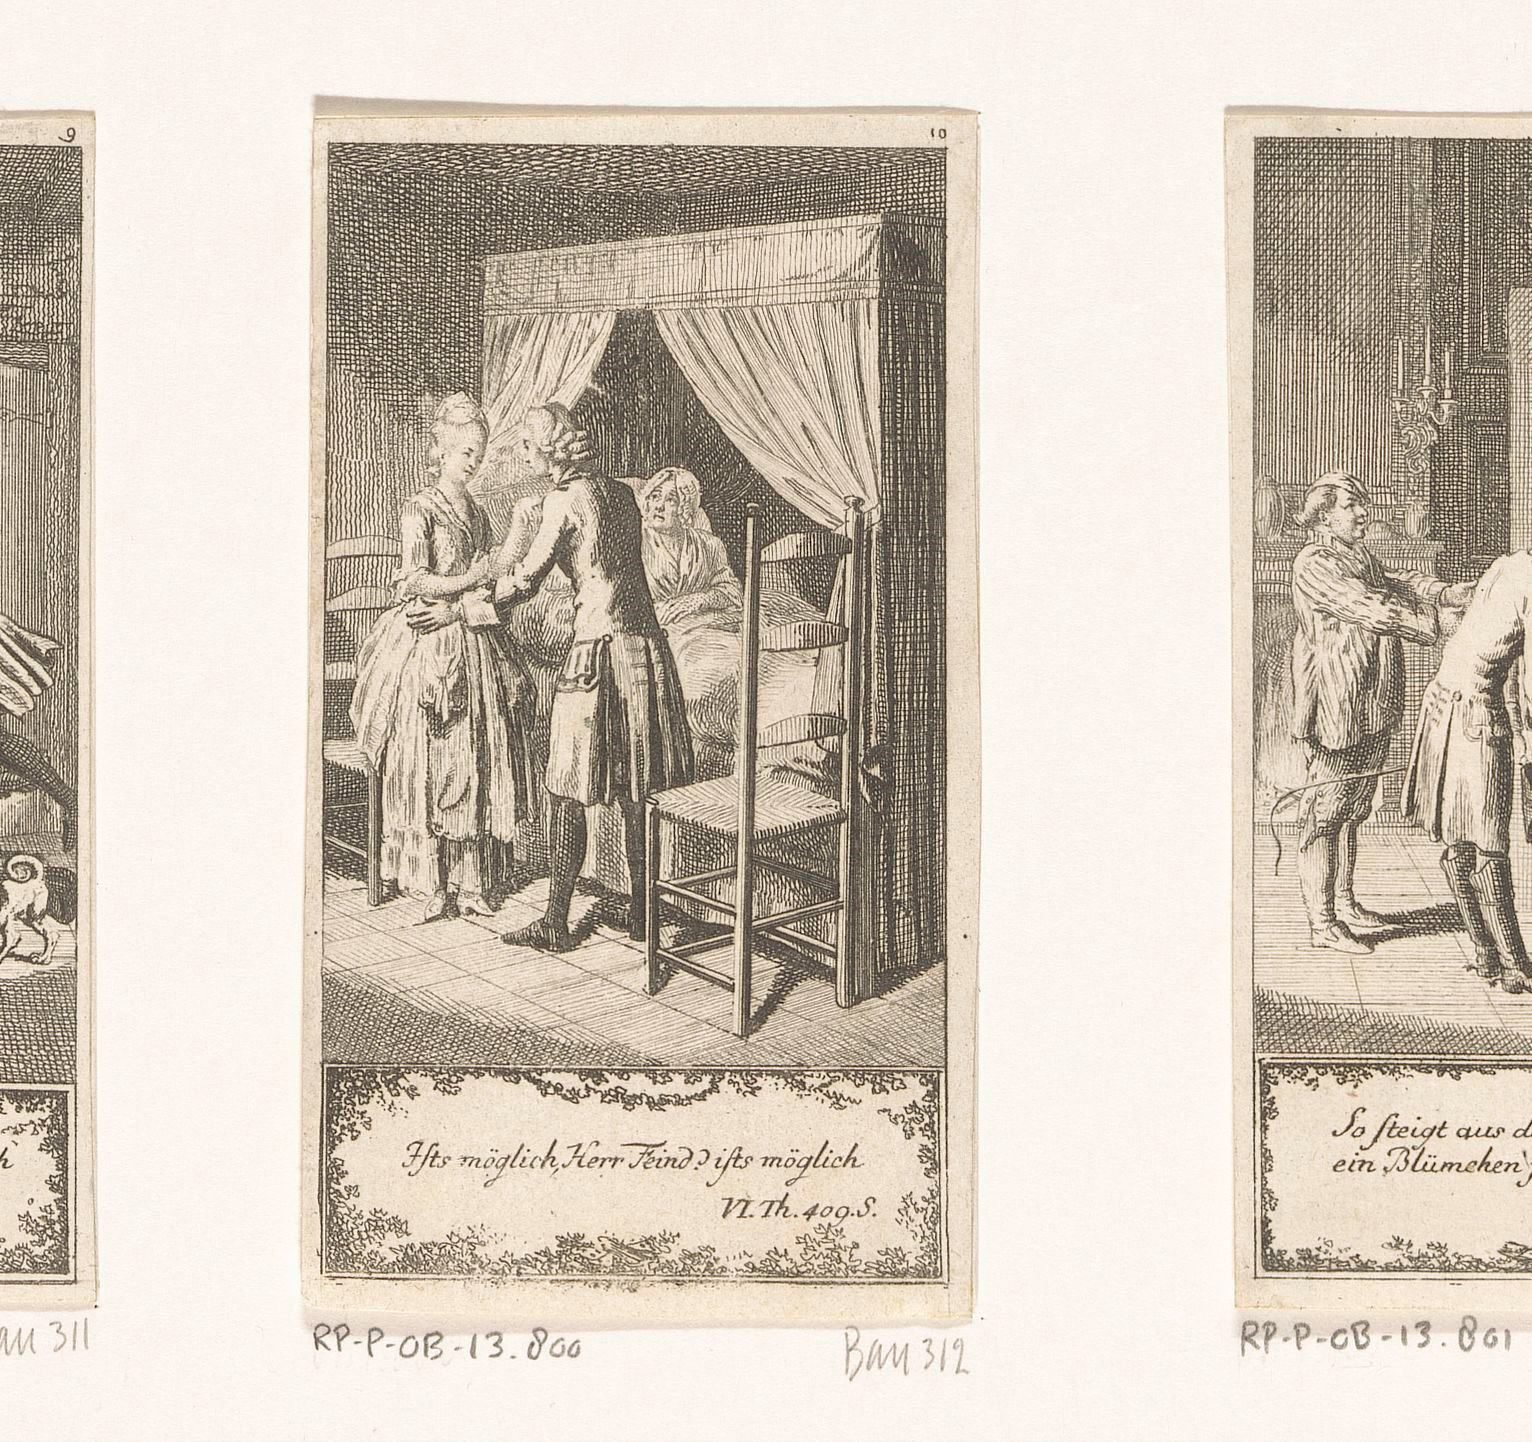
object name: print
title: Pastor Gros en Christine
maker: daniel nikolaus chodowiecki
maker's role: draughtsman, print maker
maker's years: 1726-1801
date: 1776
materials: paper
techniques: etching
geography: berlin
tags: literature, sick-bed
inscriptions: collector's mark: Lugt 2228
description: Tiende scène uit een serie van twaalf scènes die de 'Geschichte des Predigers Gros' illustreren, onderdeel van 'Sophiens Reise von Memel nach Sachsen' door Johann Timotheus Hermes. Pastor Gros von Haberstroh heet eigenlijk Karl Wagner en is de legitieme zoon van Frau E., de pleegmoeder van Sophie. Hij bedient zich ook van het alias Feind. De scènes werden op een plaat geëtst. Deze serie is ook gebruikt in: Gothaischer Hof Kalender zum Nutzen und Vergnügen eingerichtet auf das Jahr 1778. Gotha, C.W. Ettinger, s.a.